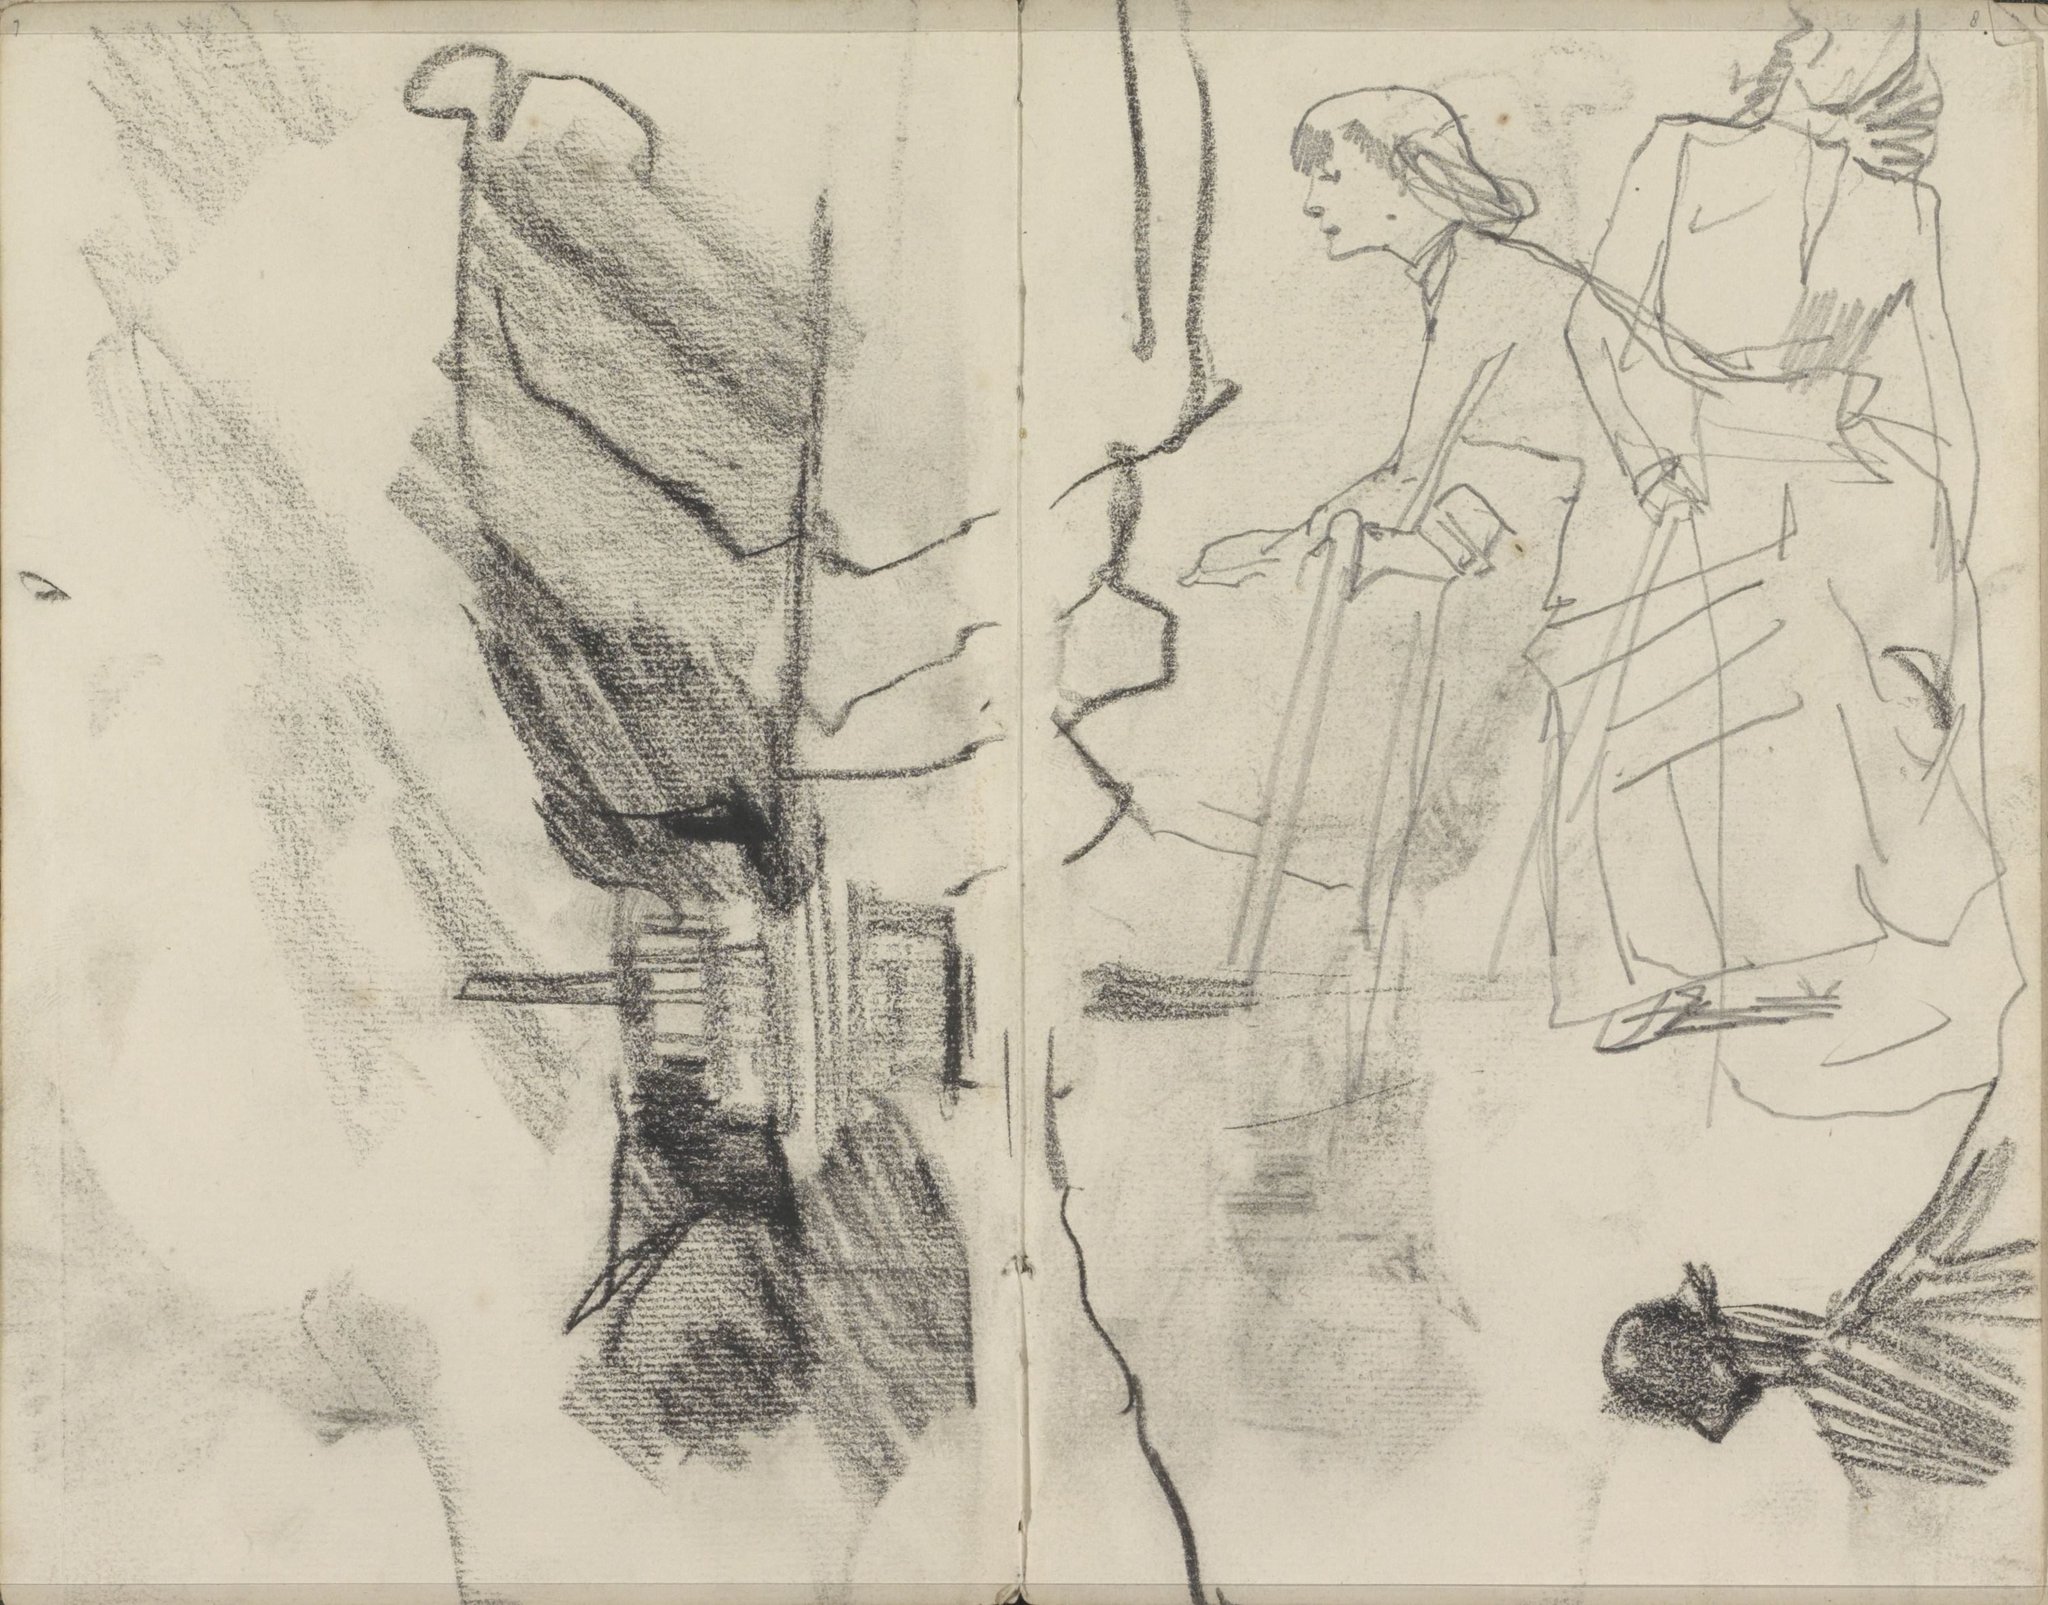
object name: sketchbook leaf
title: Stadsgezicht en figuurstudies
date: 1881-1883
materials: chalk, paper, pencil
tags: city-view, and landscape with man-made constructions, adult woman, adult man, the hague, rotterdam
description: Pagina 7 en pagina 8 uit een schetsboek met 19 bladen.